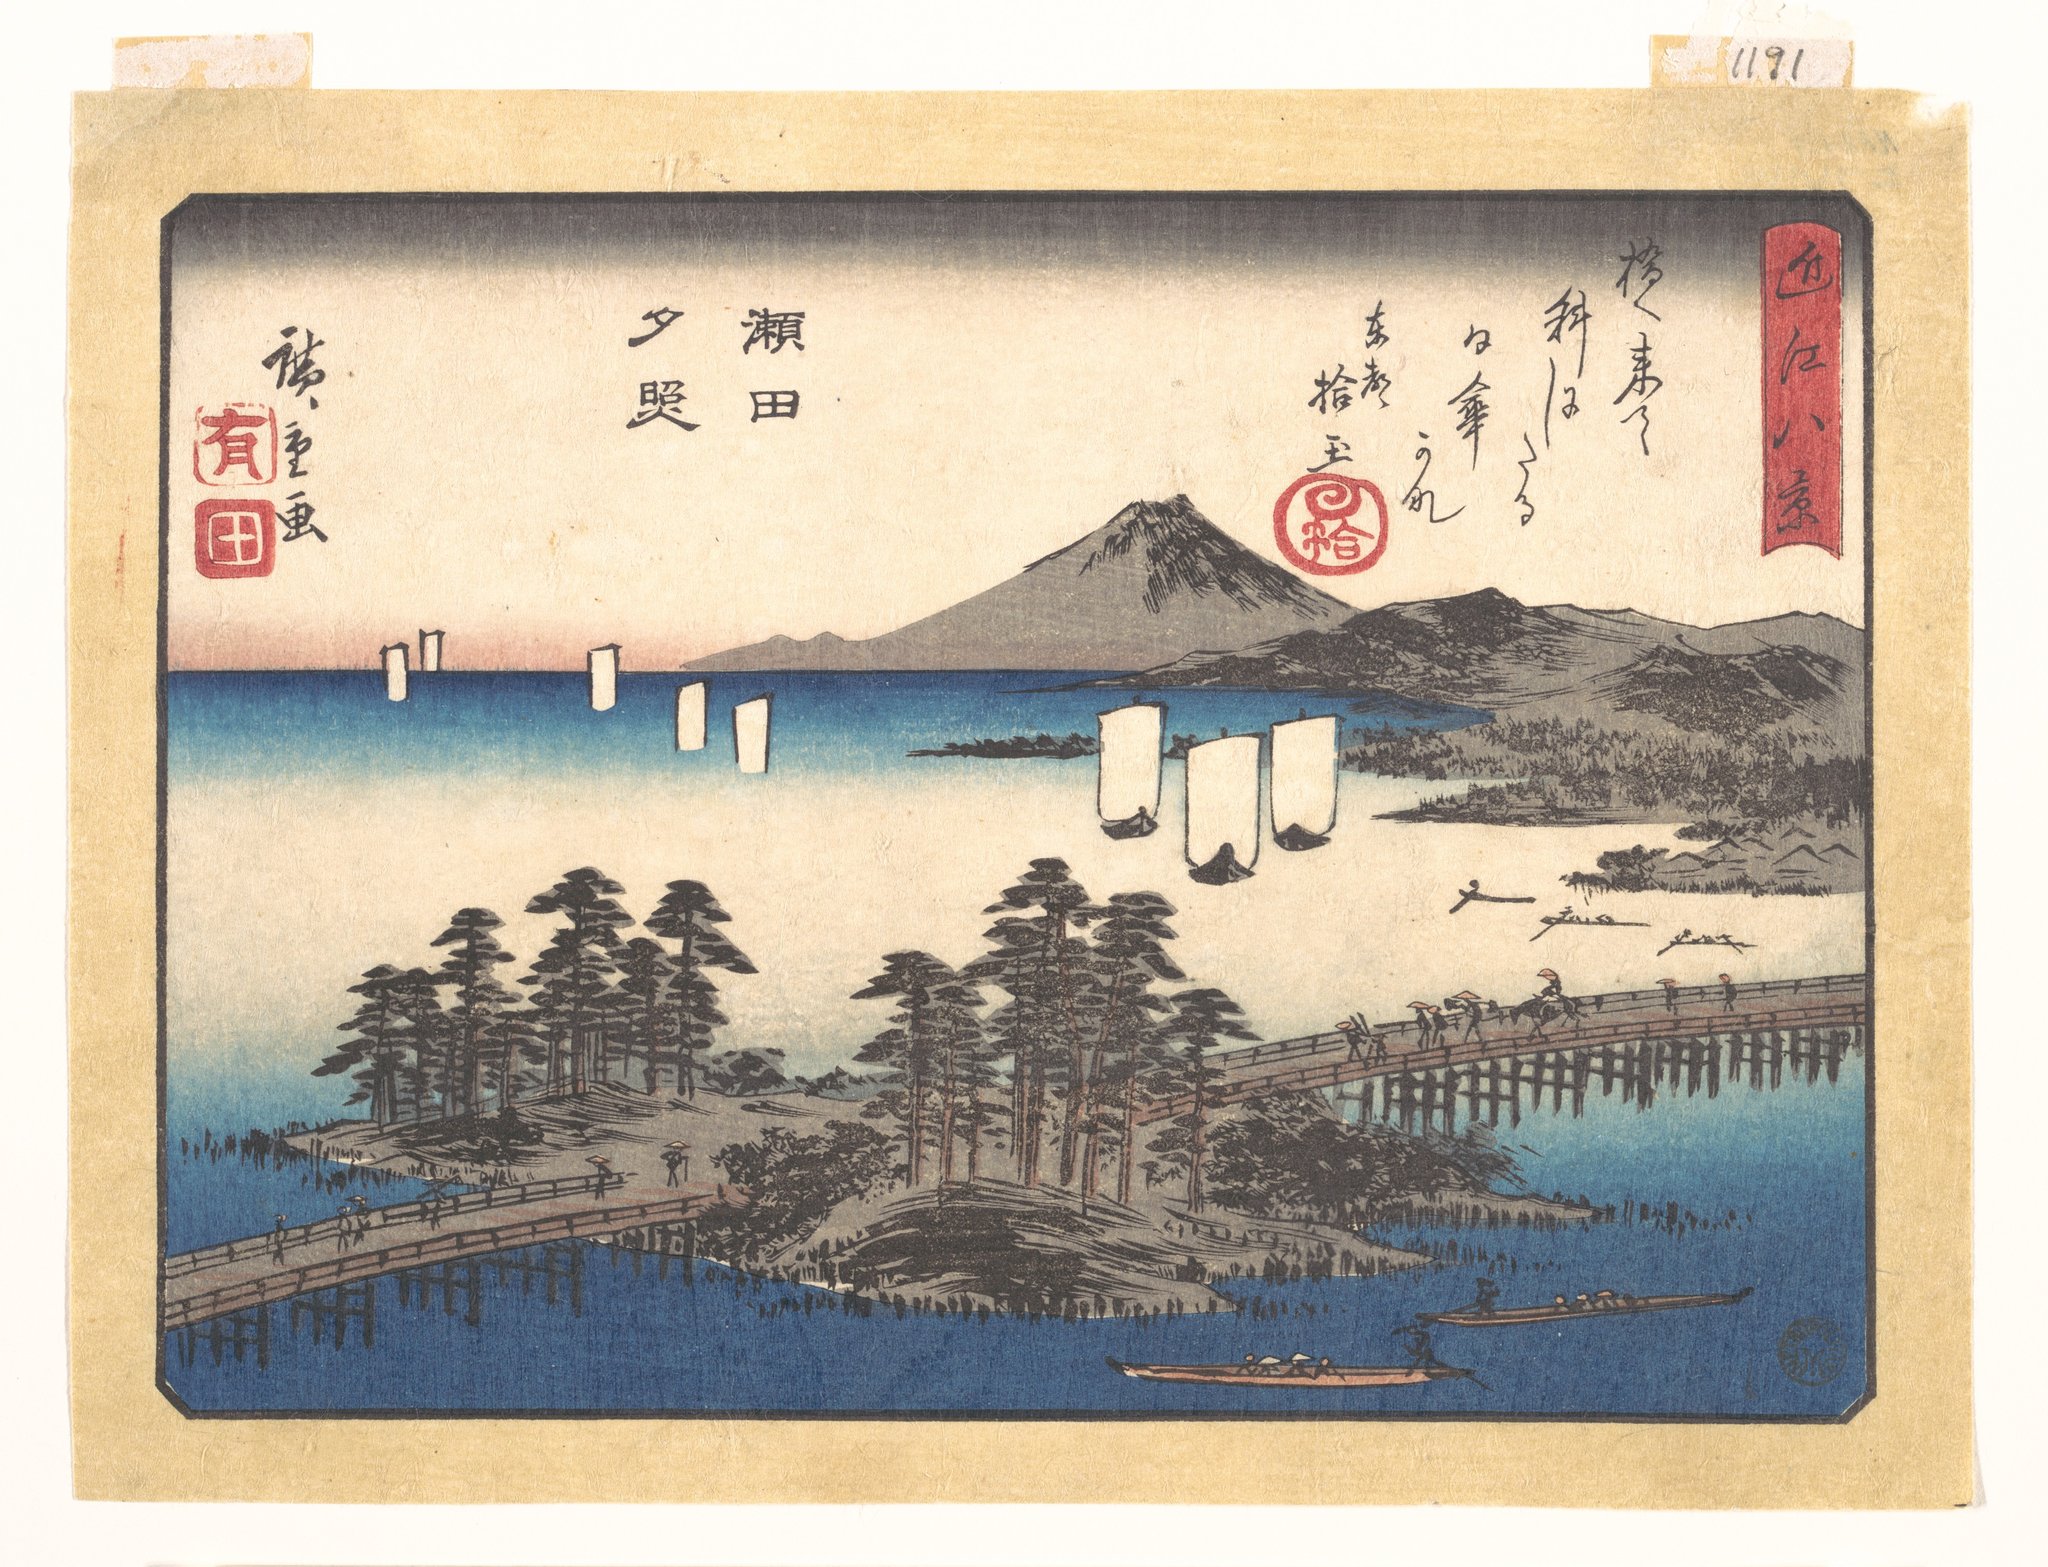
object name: print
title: Sunset Glow at Seta, from the series Eight Views of Ōmi (Ōmi hakkei)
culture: japanese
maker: utagawa hiroshige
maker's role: artist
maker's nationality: japanese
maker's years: 1797-1858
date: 1834-1835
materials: ink, paper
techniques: woodblock print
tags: bridges,mountains,landscapes,boats